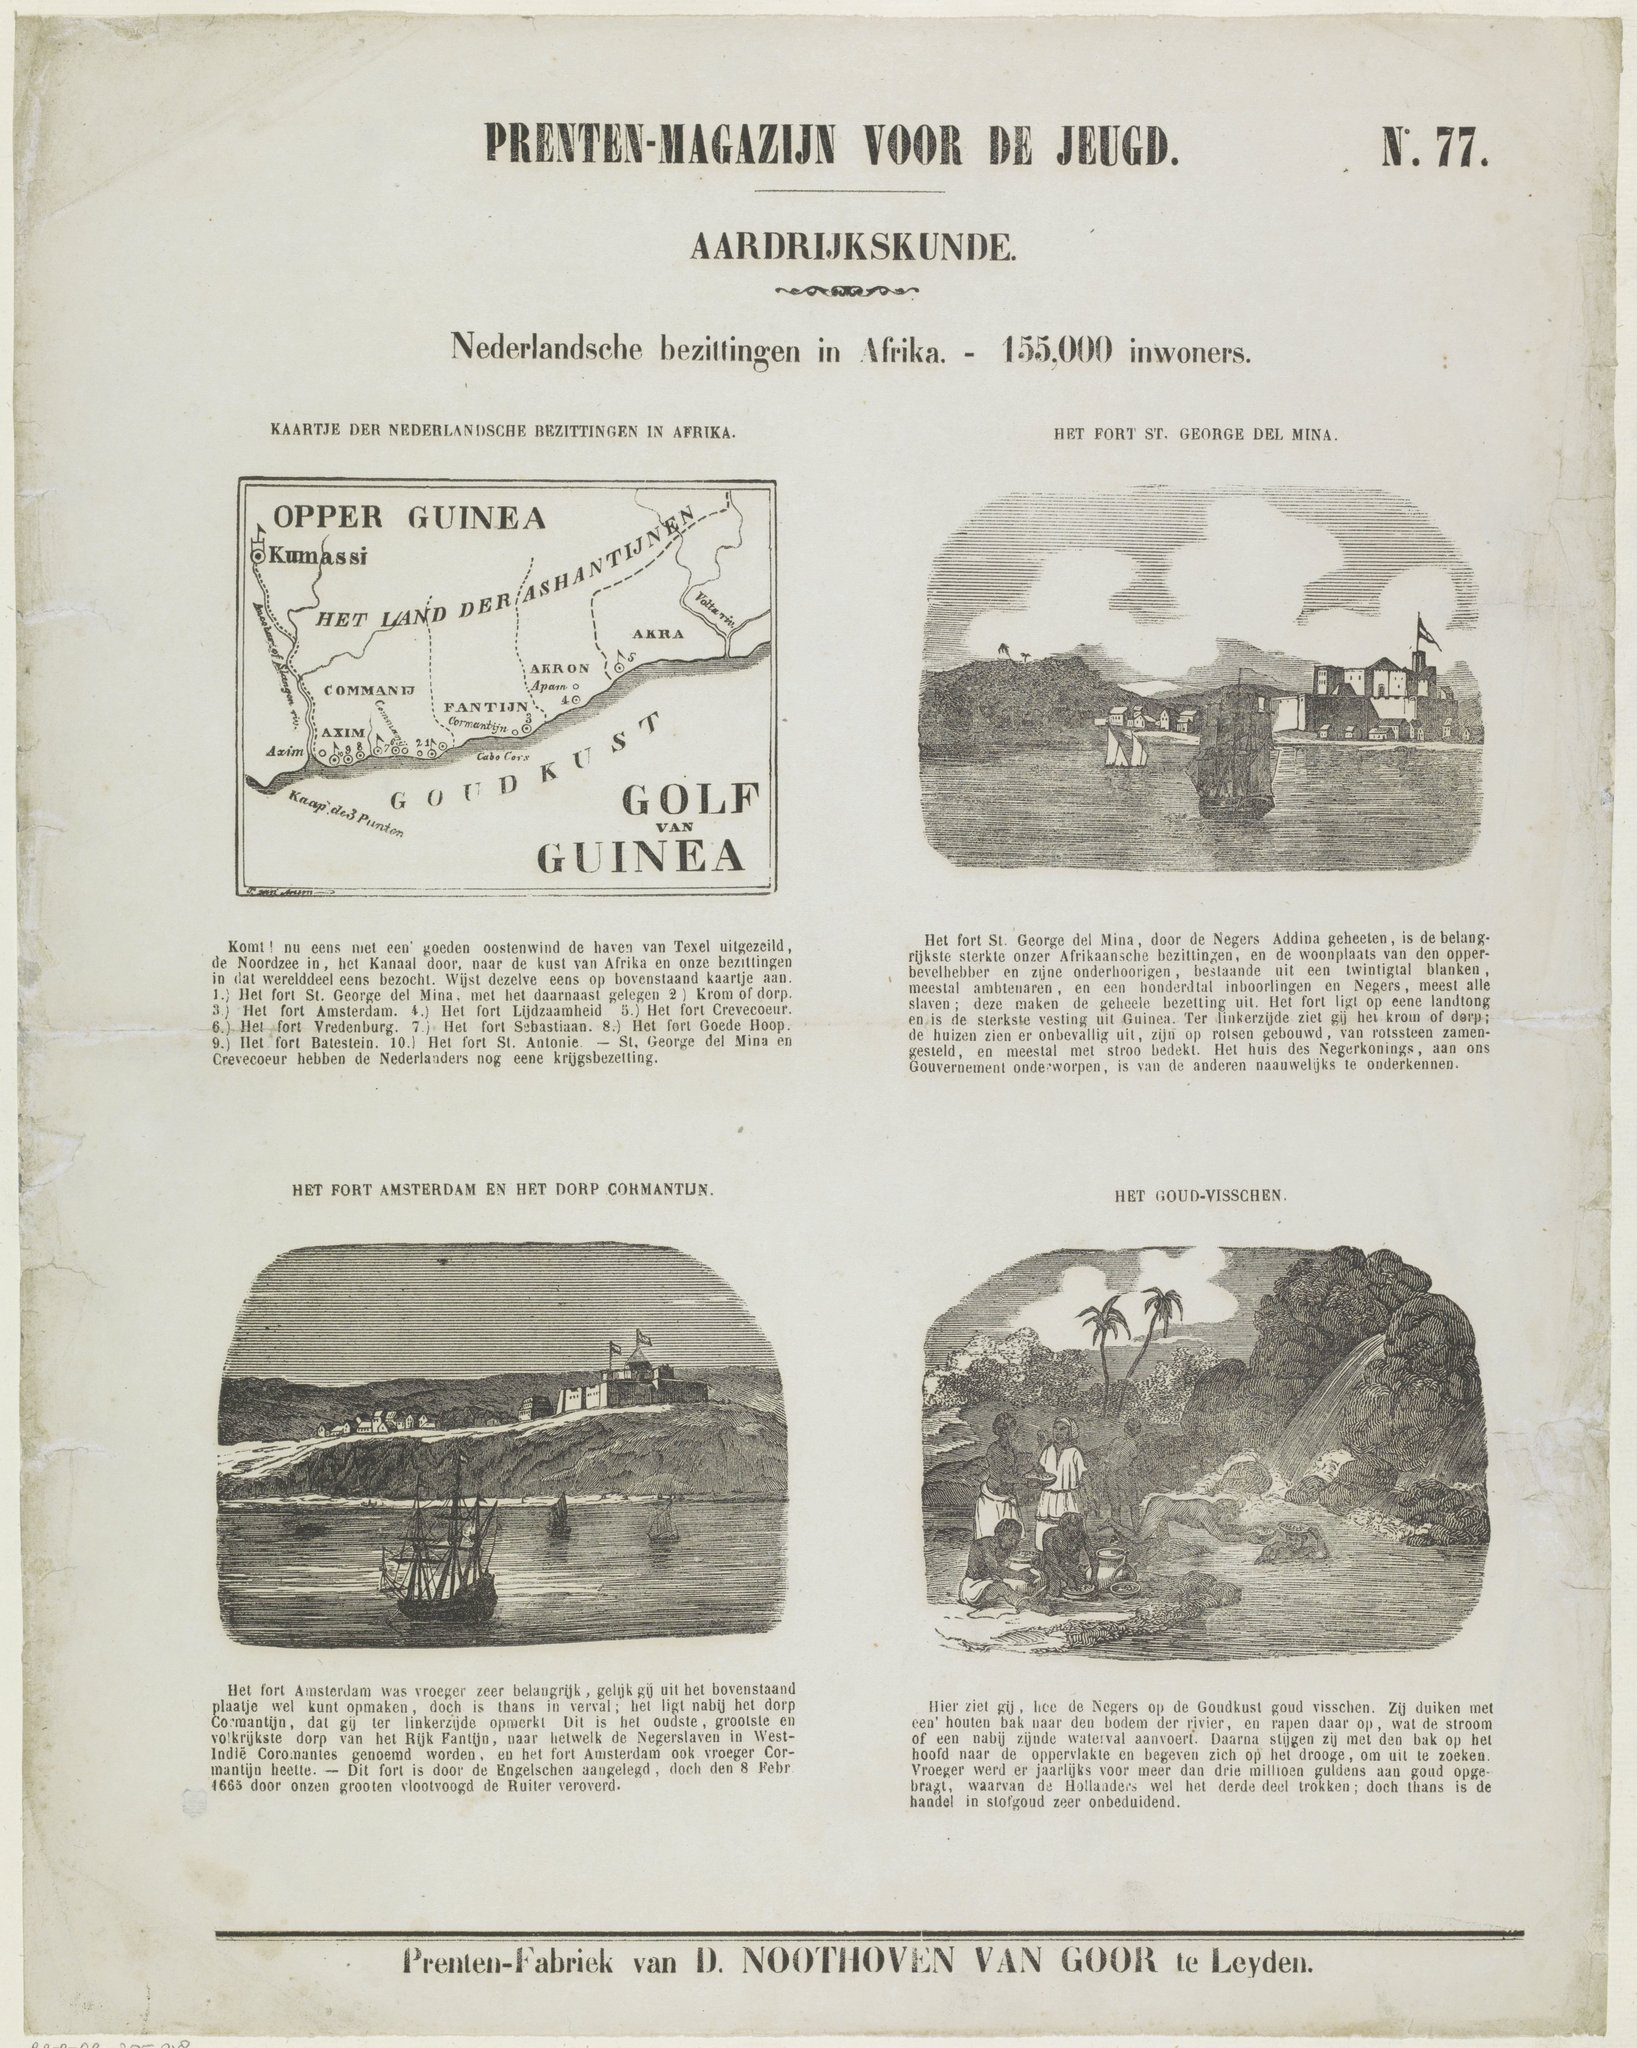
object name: print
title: Nederlandsche bezittingen in Afrika. - 155,000 inwoners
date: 1850-1881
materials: paper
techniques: letterpress printing, engraving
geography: netherlands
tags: colonial system, (map of) africa, ford, maps, atlases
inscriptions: collector's mark: Lugt 2760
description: Blad met 4 voorstellingen van Nederlandse bezittingen in Afrika. Een kaart en voorstellingen van belangrijke gebouwen, zoals het Fort St. Jorge del Mina en het Fort Amsterdam. Boven elke voorstelling een titel en onder elke voorstelling een vierregelig vers. Genummerd rechtsboven: No. 77.